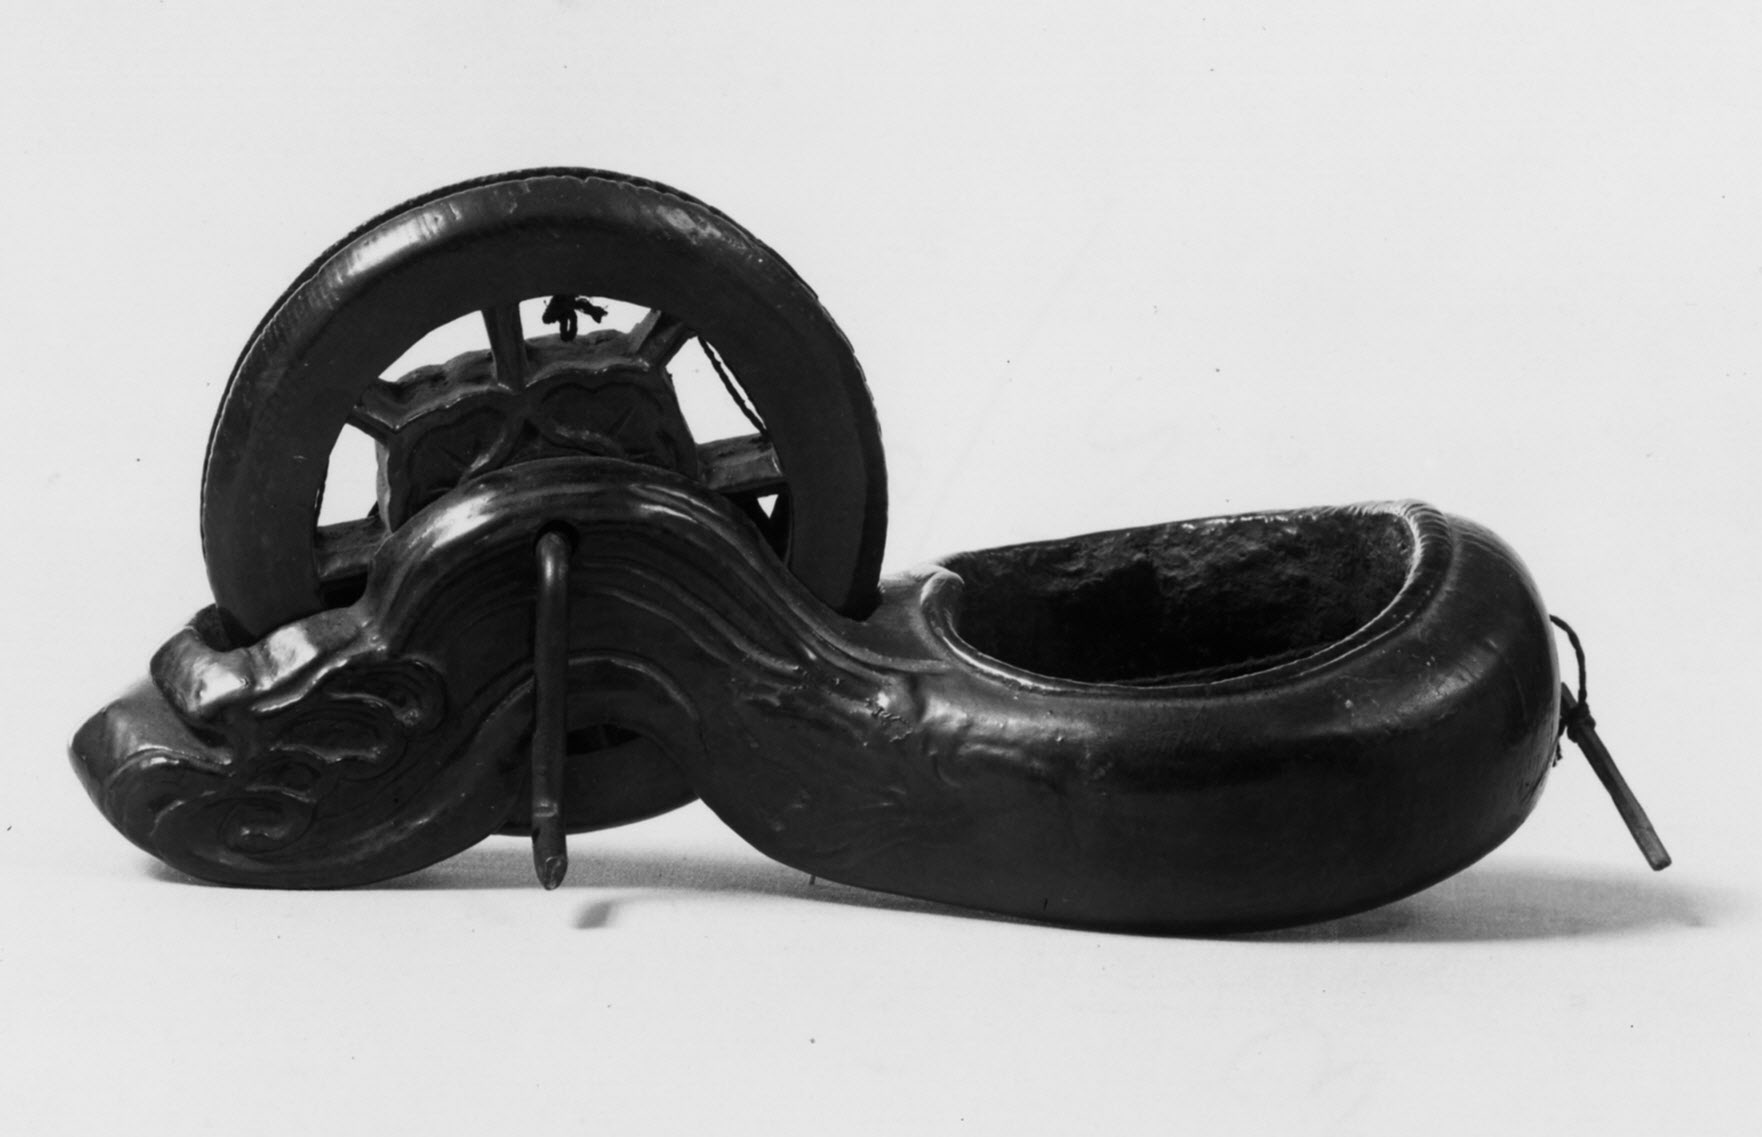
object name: carpenter's chalk line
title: Carpenter's Chalk-Line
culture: japanese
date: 1801-1900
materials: wood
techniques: lacquer